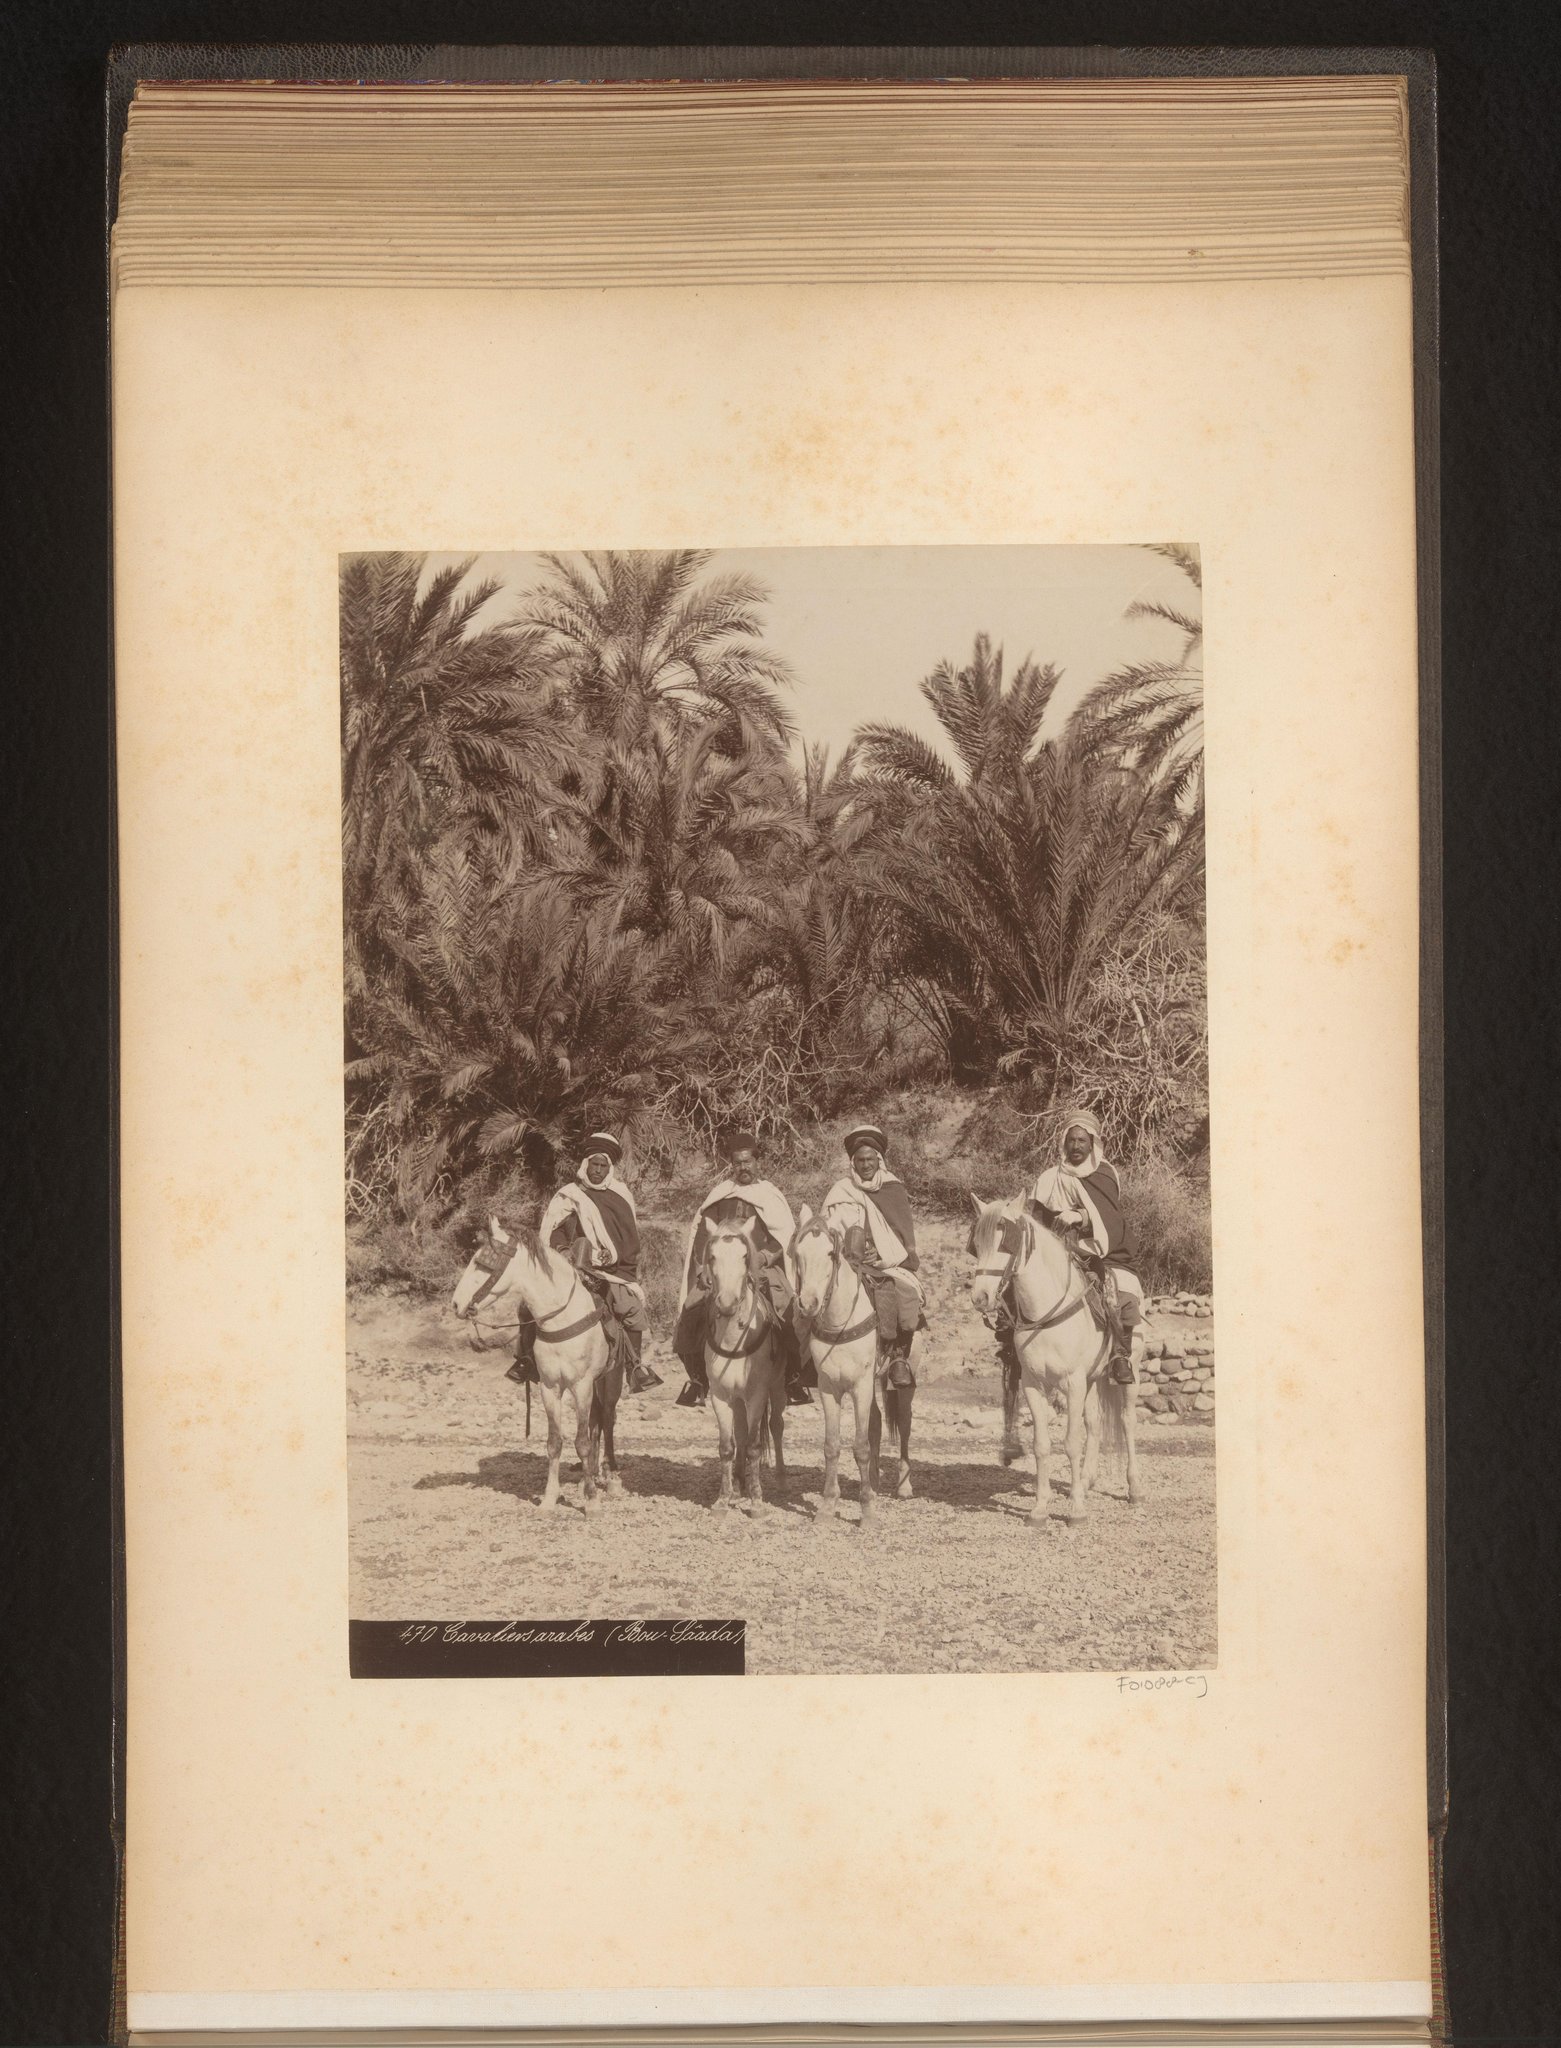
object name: album leaf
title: Cavaliers arabes (Bou - Saada)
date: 1880-1890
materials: photographic support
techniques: albumen print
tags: riding a horse, ass, or mule; rider, horseman, adult man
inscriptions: check stamp: ‘J. Kuhn Editeur/ 220 Rue de Rivoli Paris’, number: ‘470’